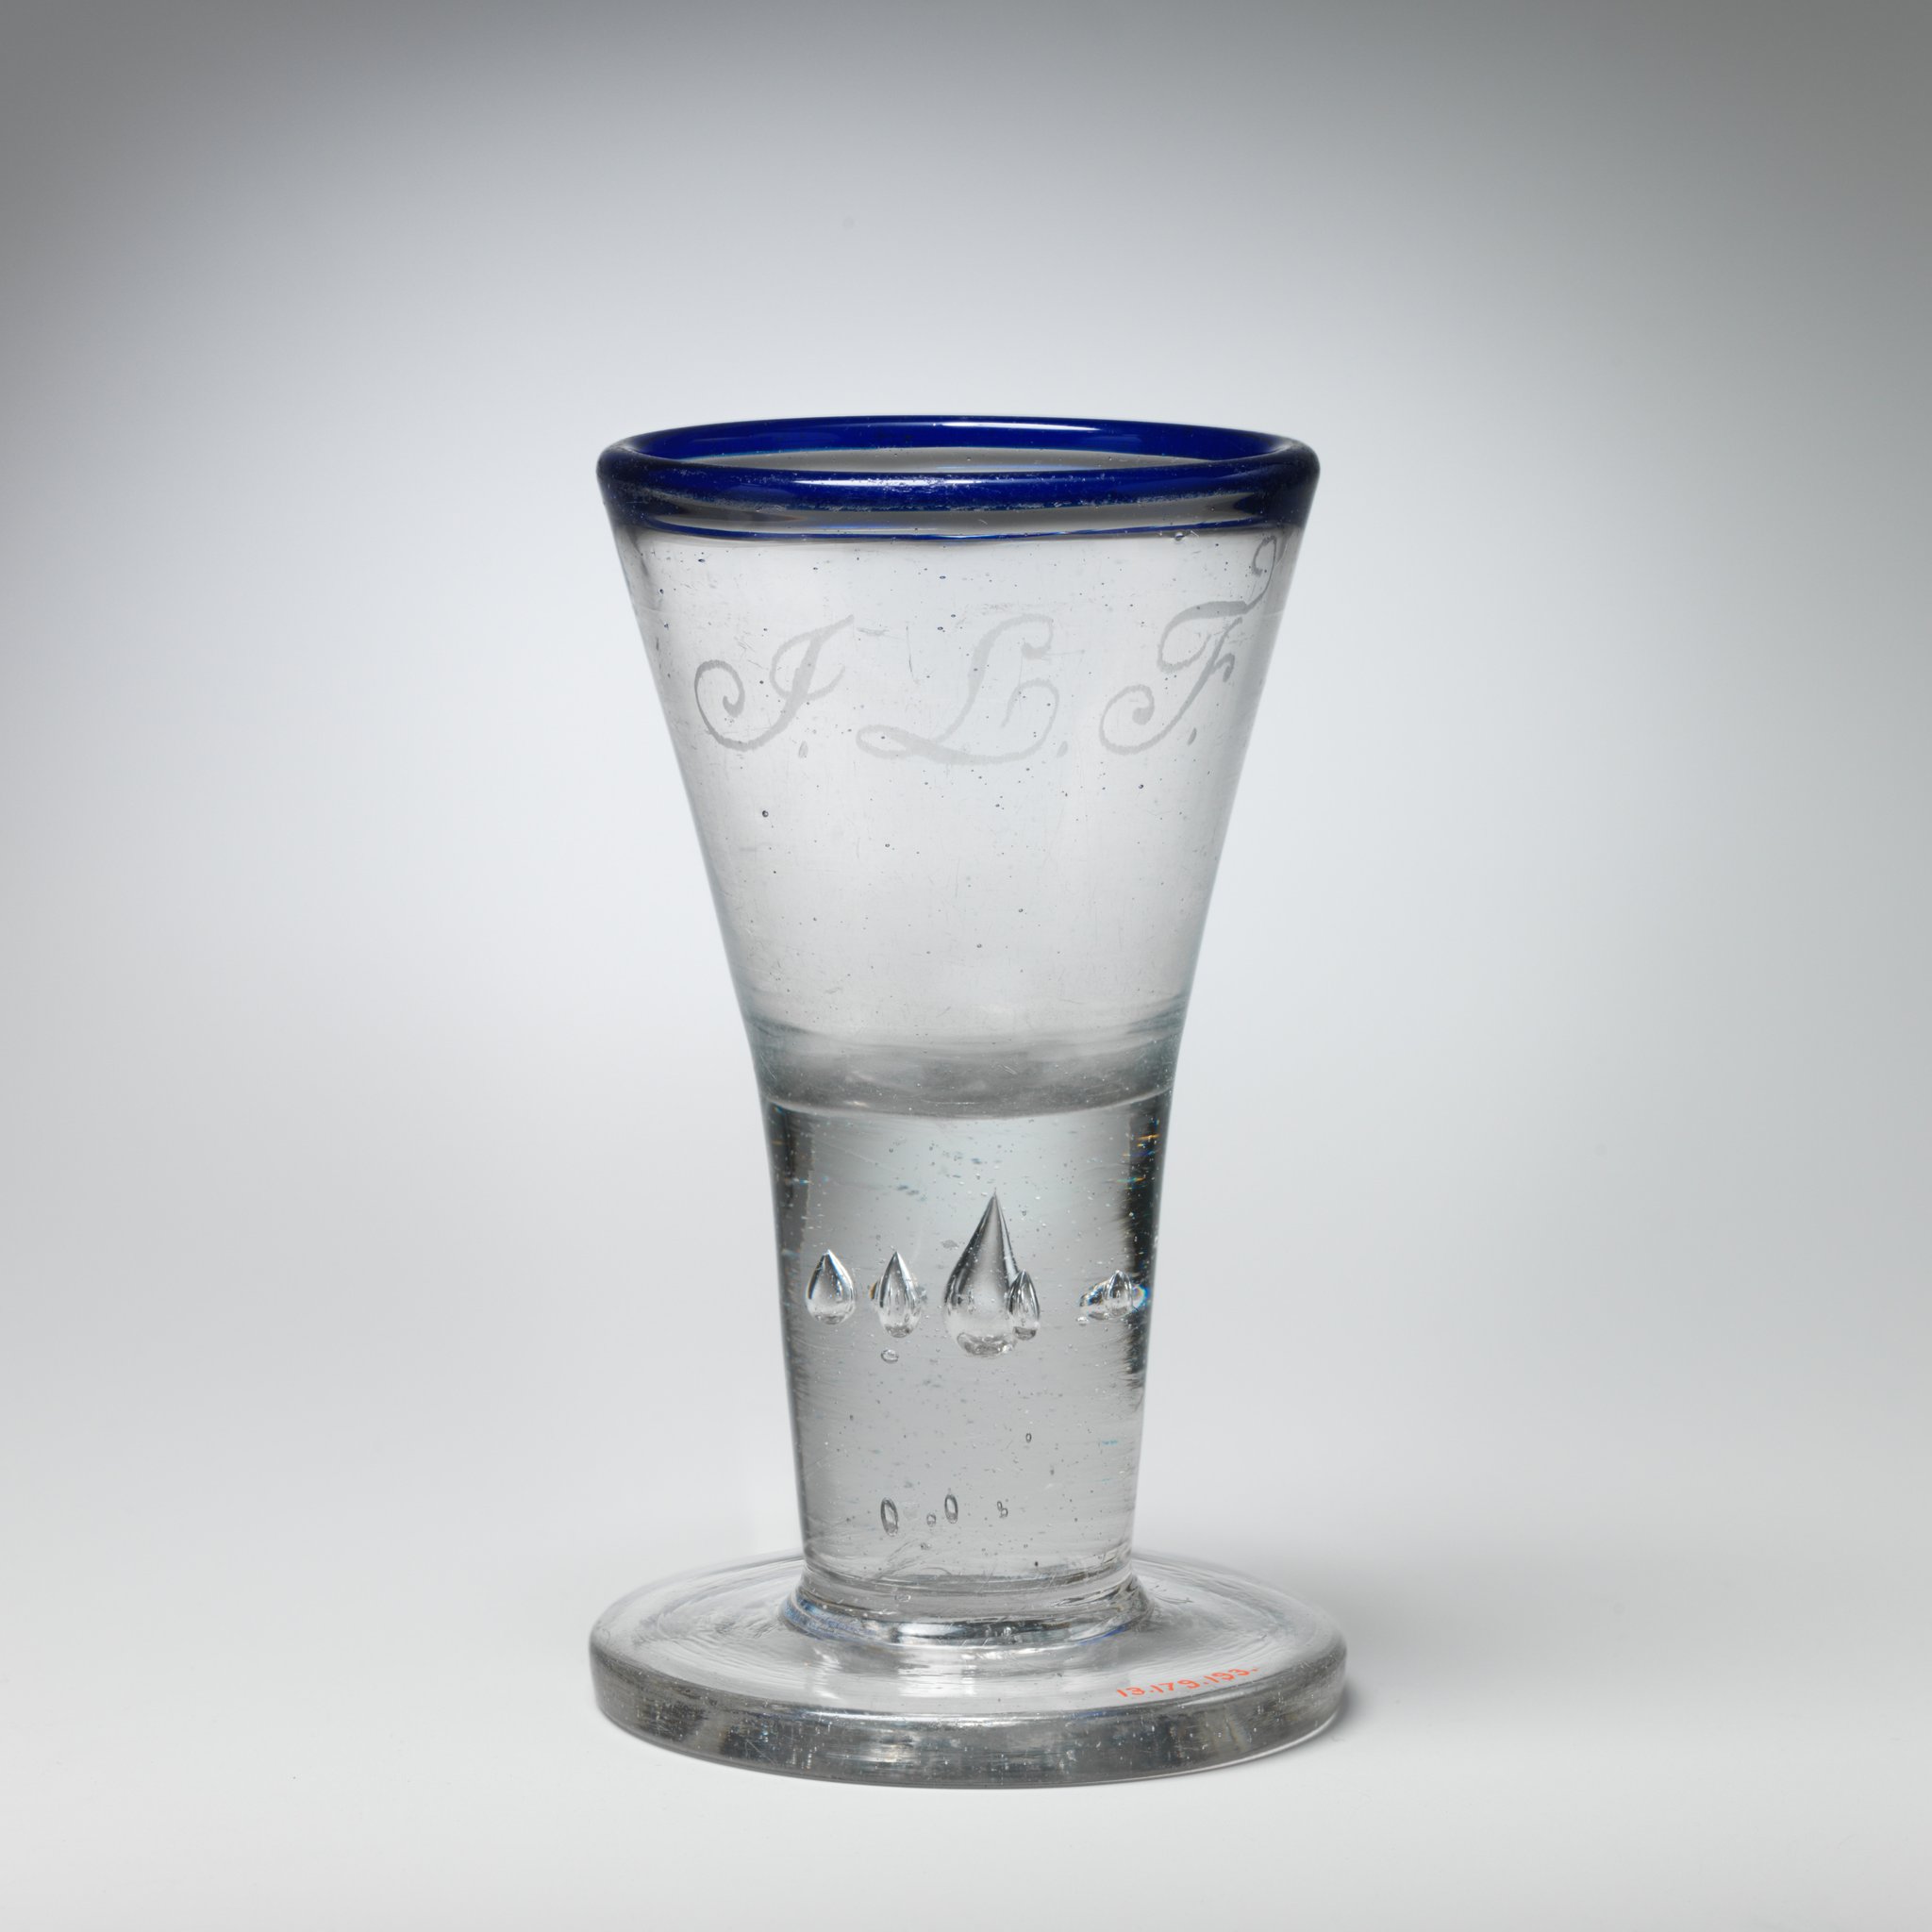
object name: firing glass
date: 1701-1800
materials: glass